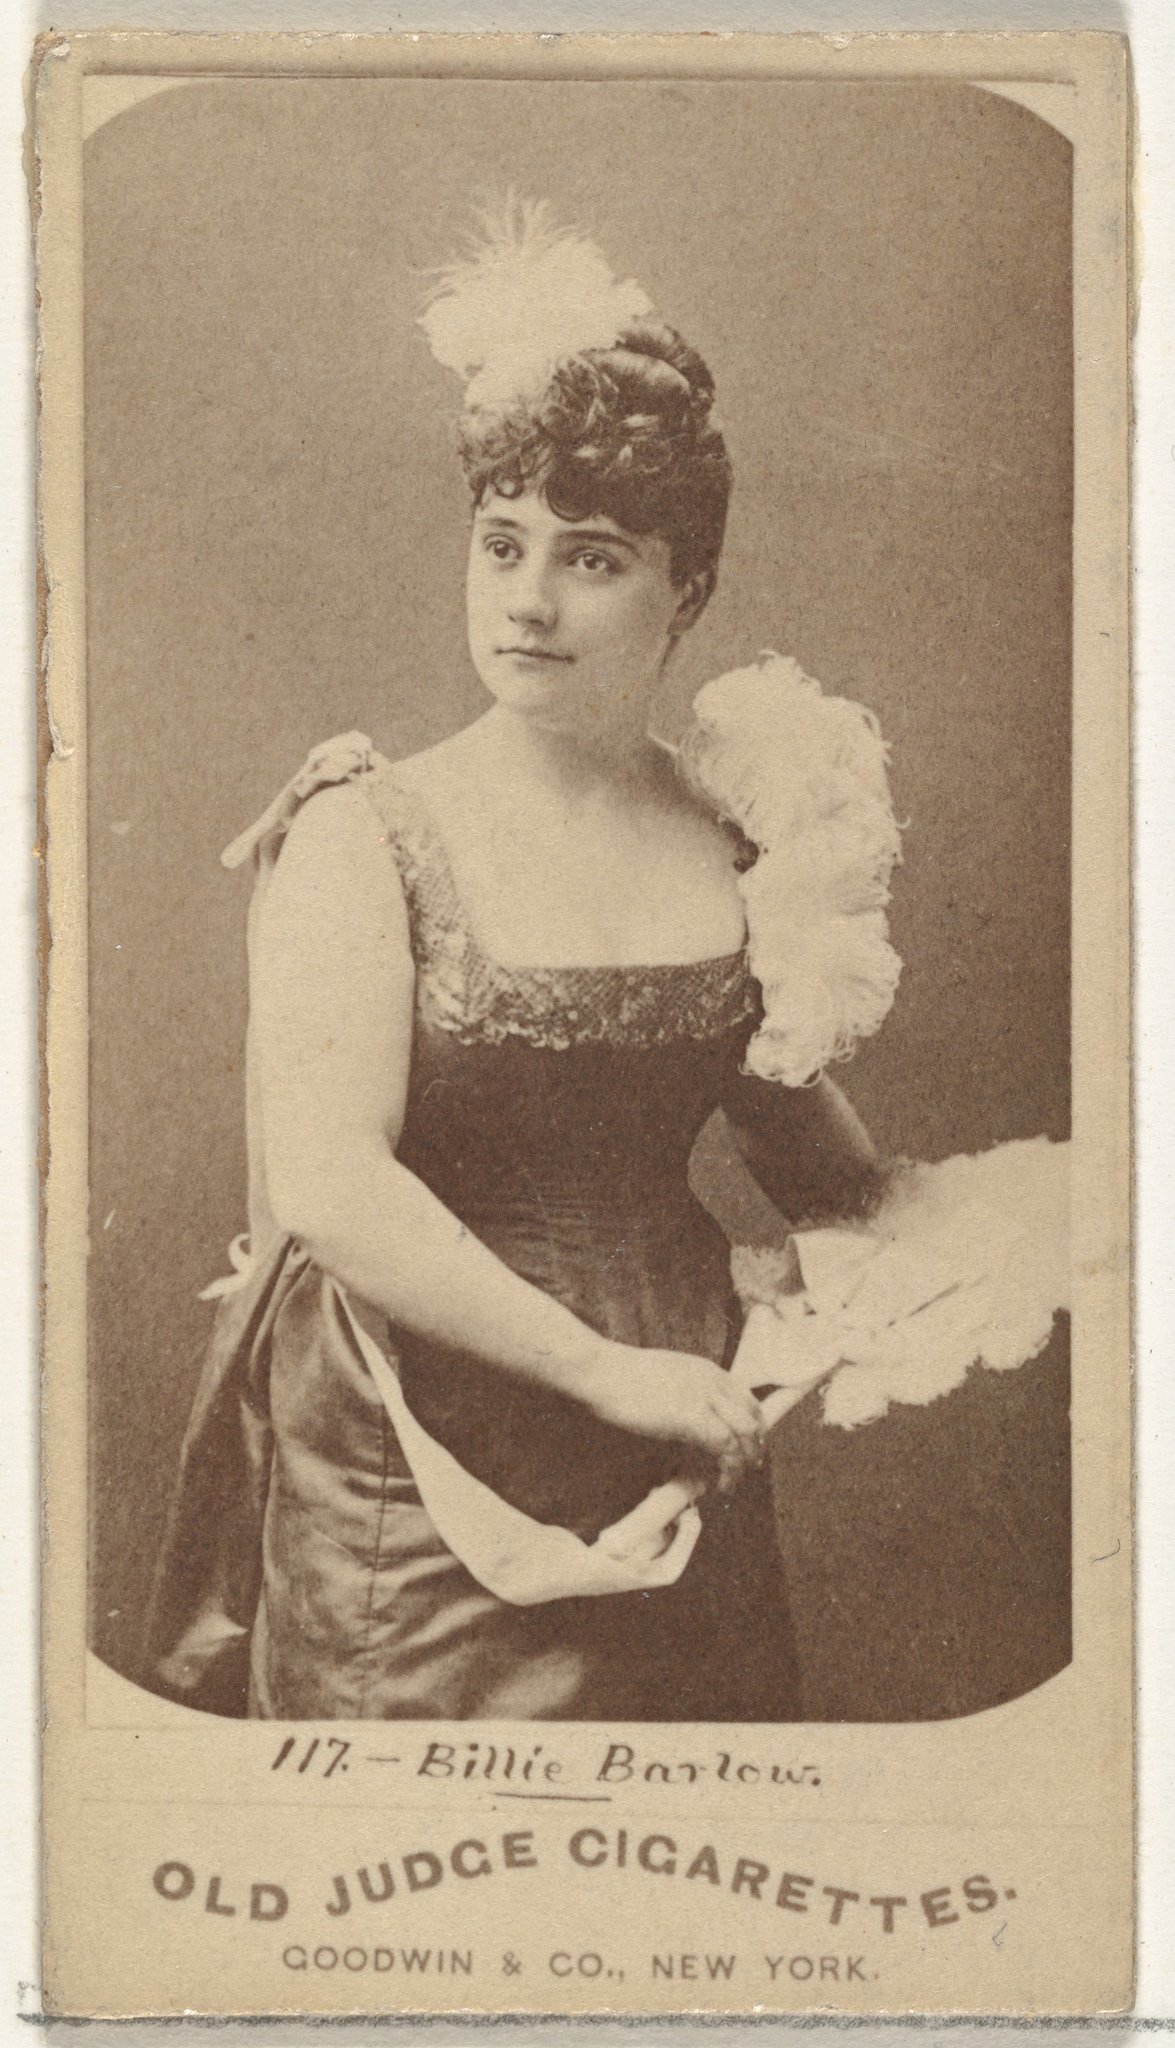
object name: photograph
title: Billie Barlow, from the Actors and Actresses series (N171) for Old Judge Cigarettes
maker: goodwin & company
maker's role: publisher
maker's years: 1850-1950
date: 1886-1890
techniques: albumen silver print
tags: portraits,women,actresses